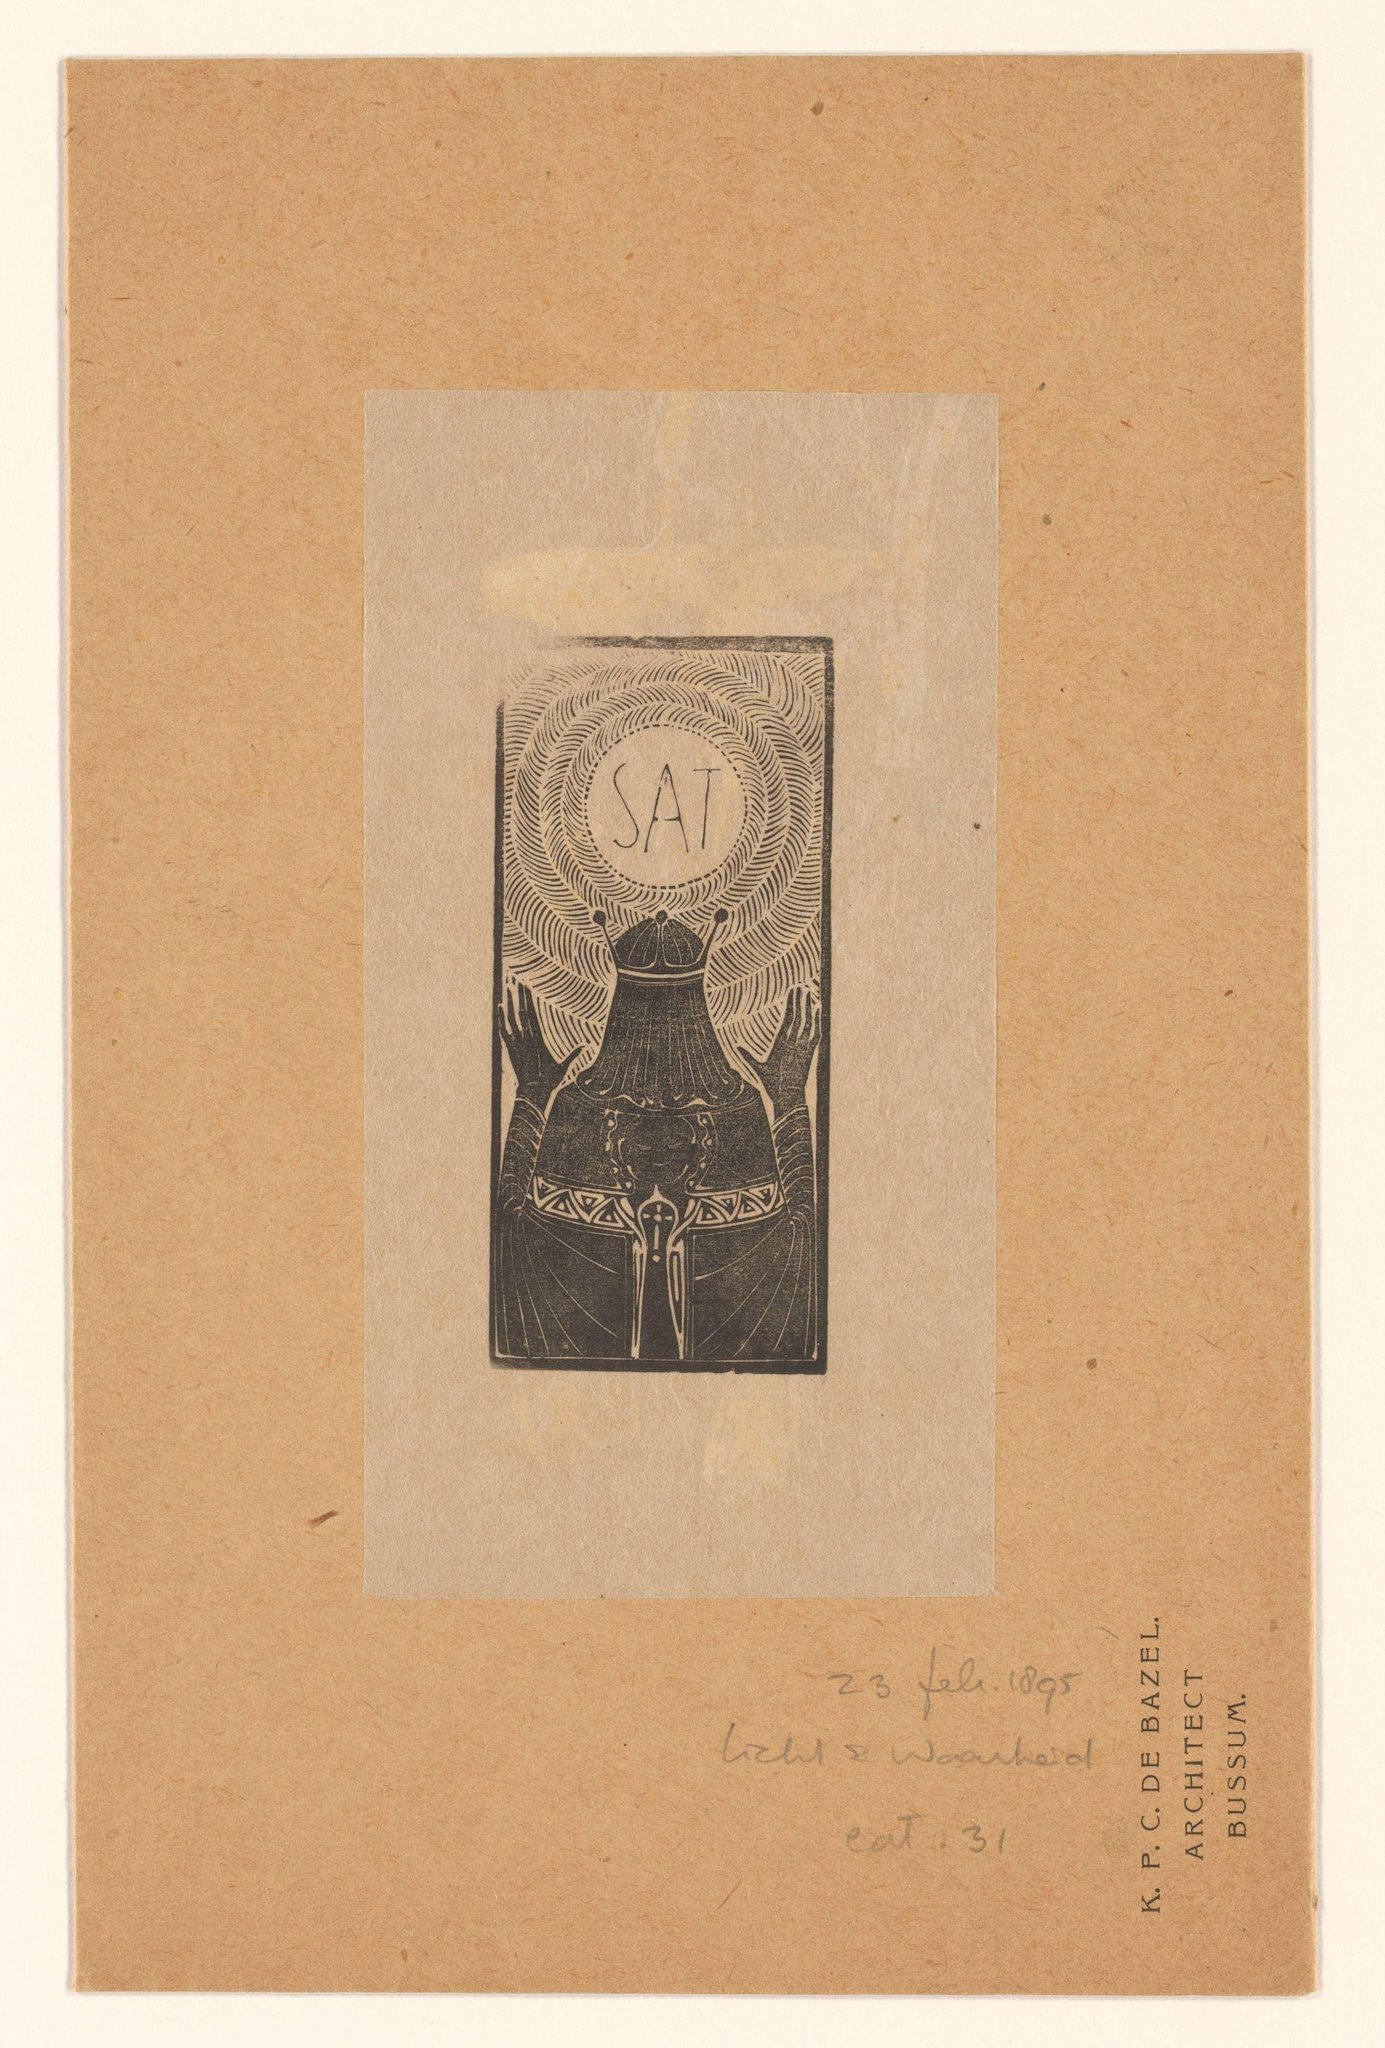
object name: print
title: Aan de zon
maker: karel petrus cornelis de bazel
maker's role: draughtsman, print maker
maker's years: 1869-1923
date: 1895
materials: paper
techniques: woodcut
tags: sun as celestial body, king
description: Deze prent is gebruikt voor: Licht en waarheid. Orgaan van de Vereeniging 'Wie denkt overwint', 23 februari 1895, bij het gelijknamige gedicht. De prent is geplakt op een envelop met rechtsonder de tekst 'K.P.C. de Bazel. Architect Bussum.'